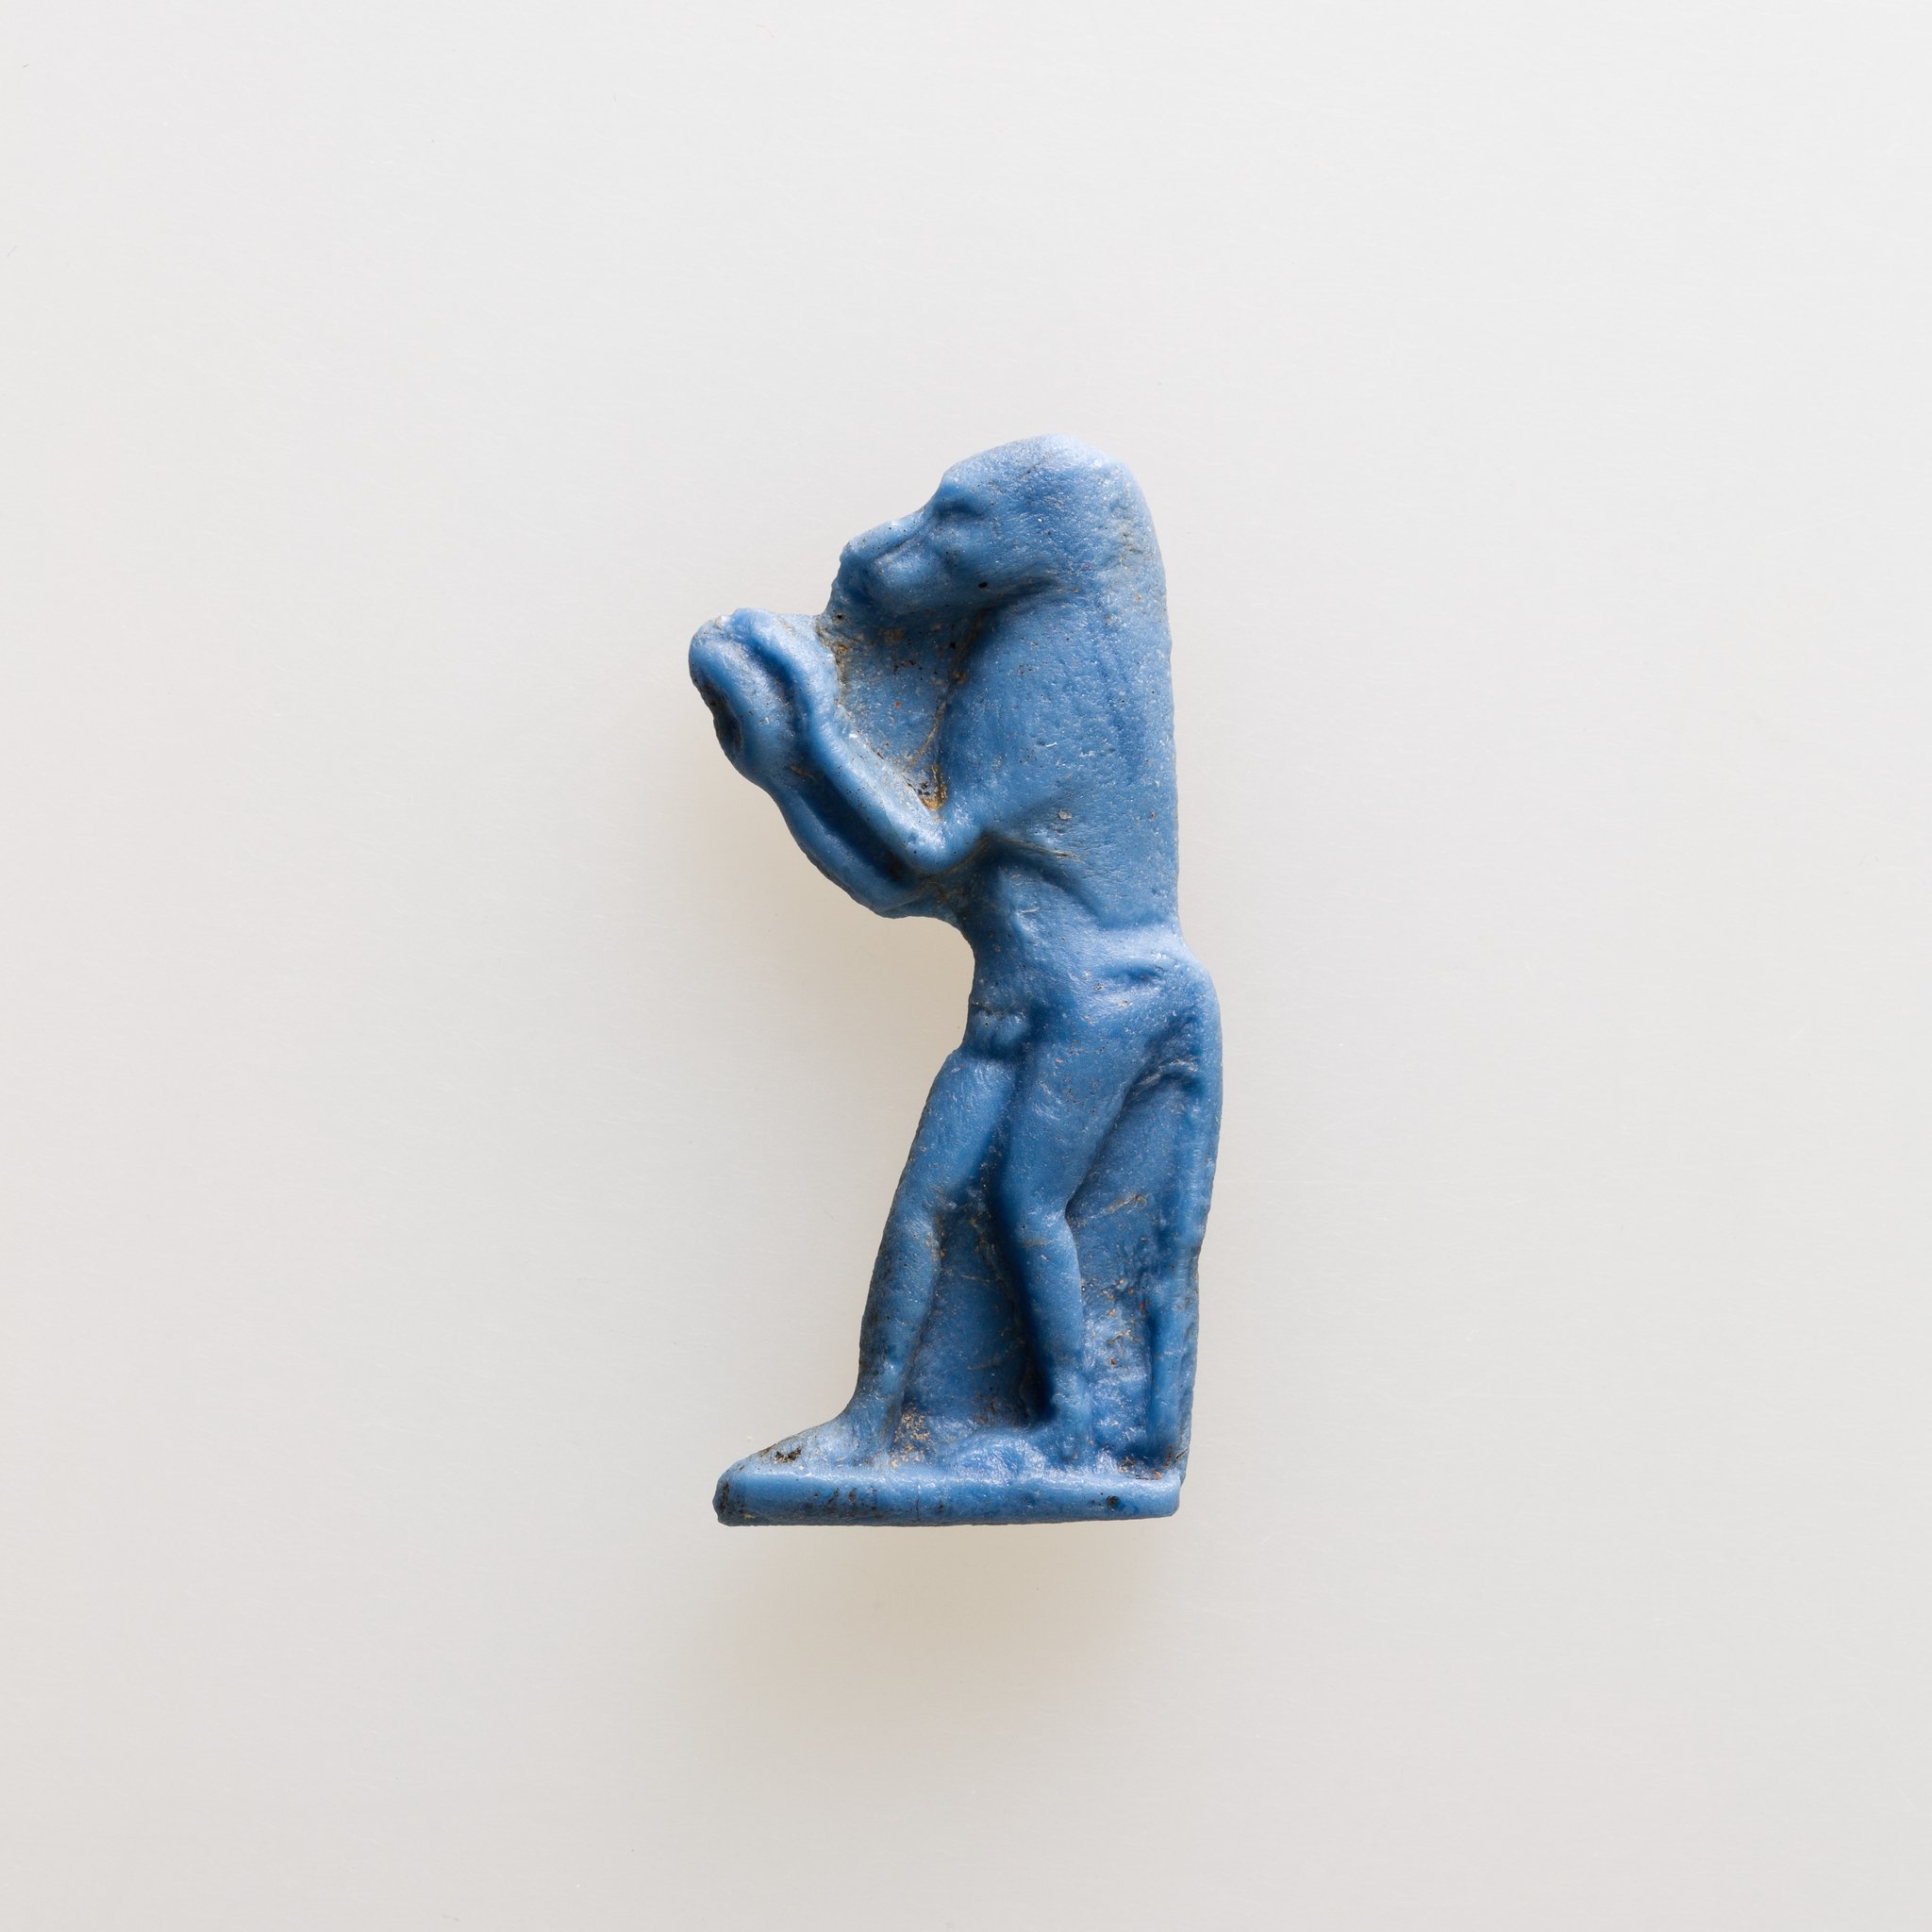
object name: amulet, baboon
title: Amulet of baboon in act of adoration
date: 525-30 BCE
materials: glass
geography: egypt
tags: baboons